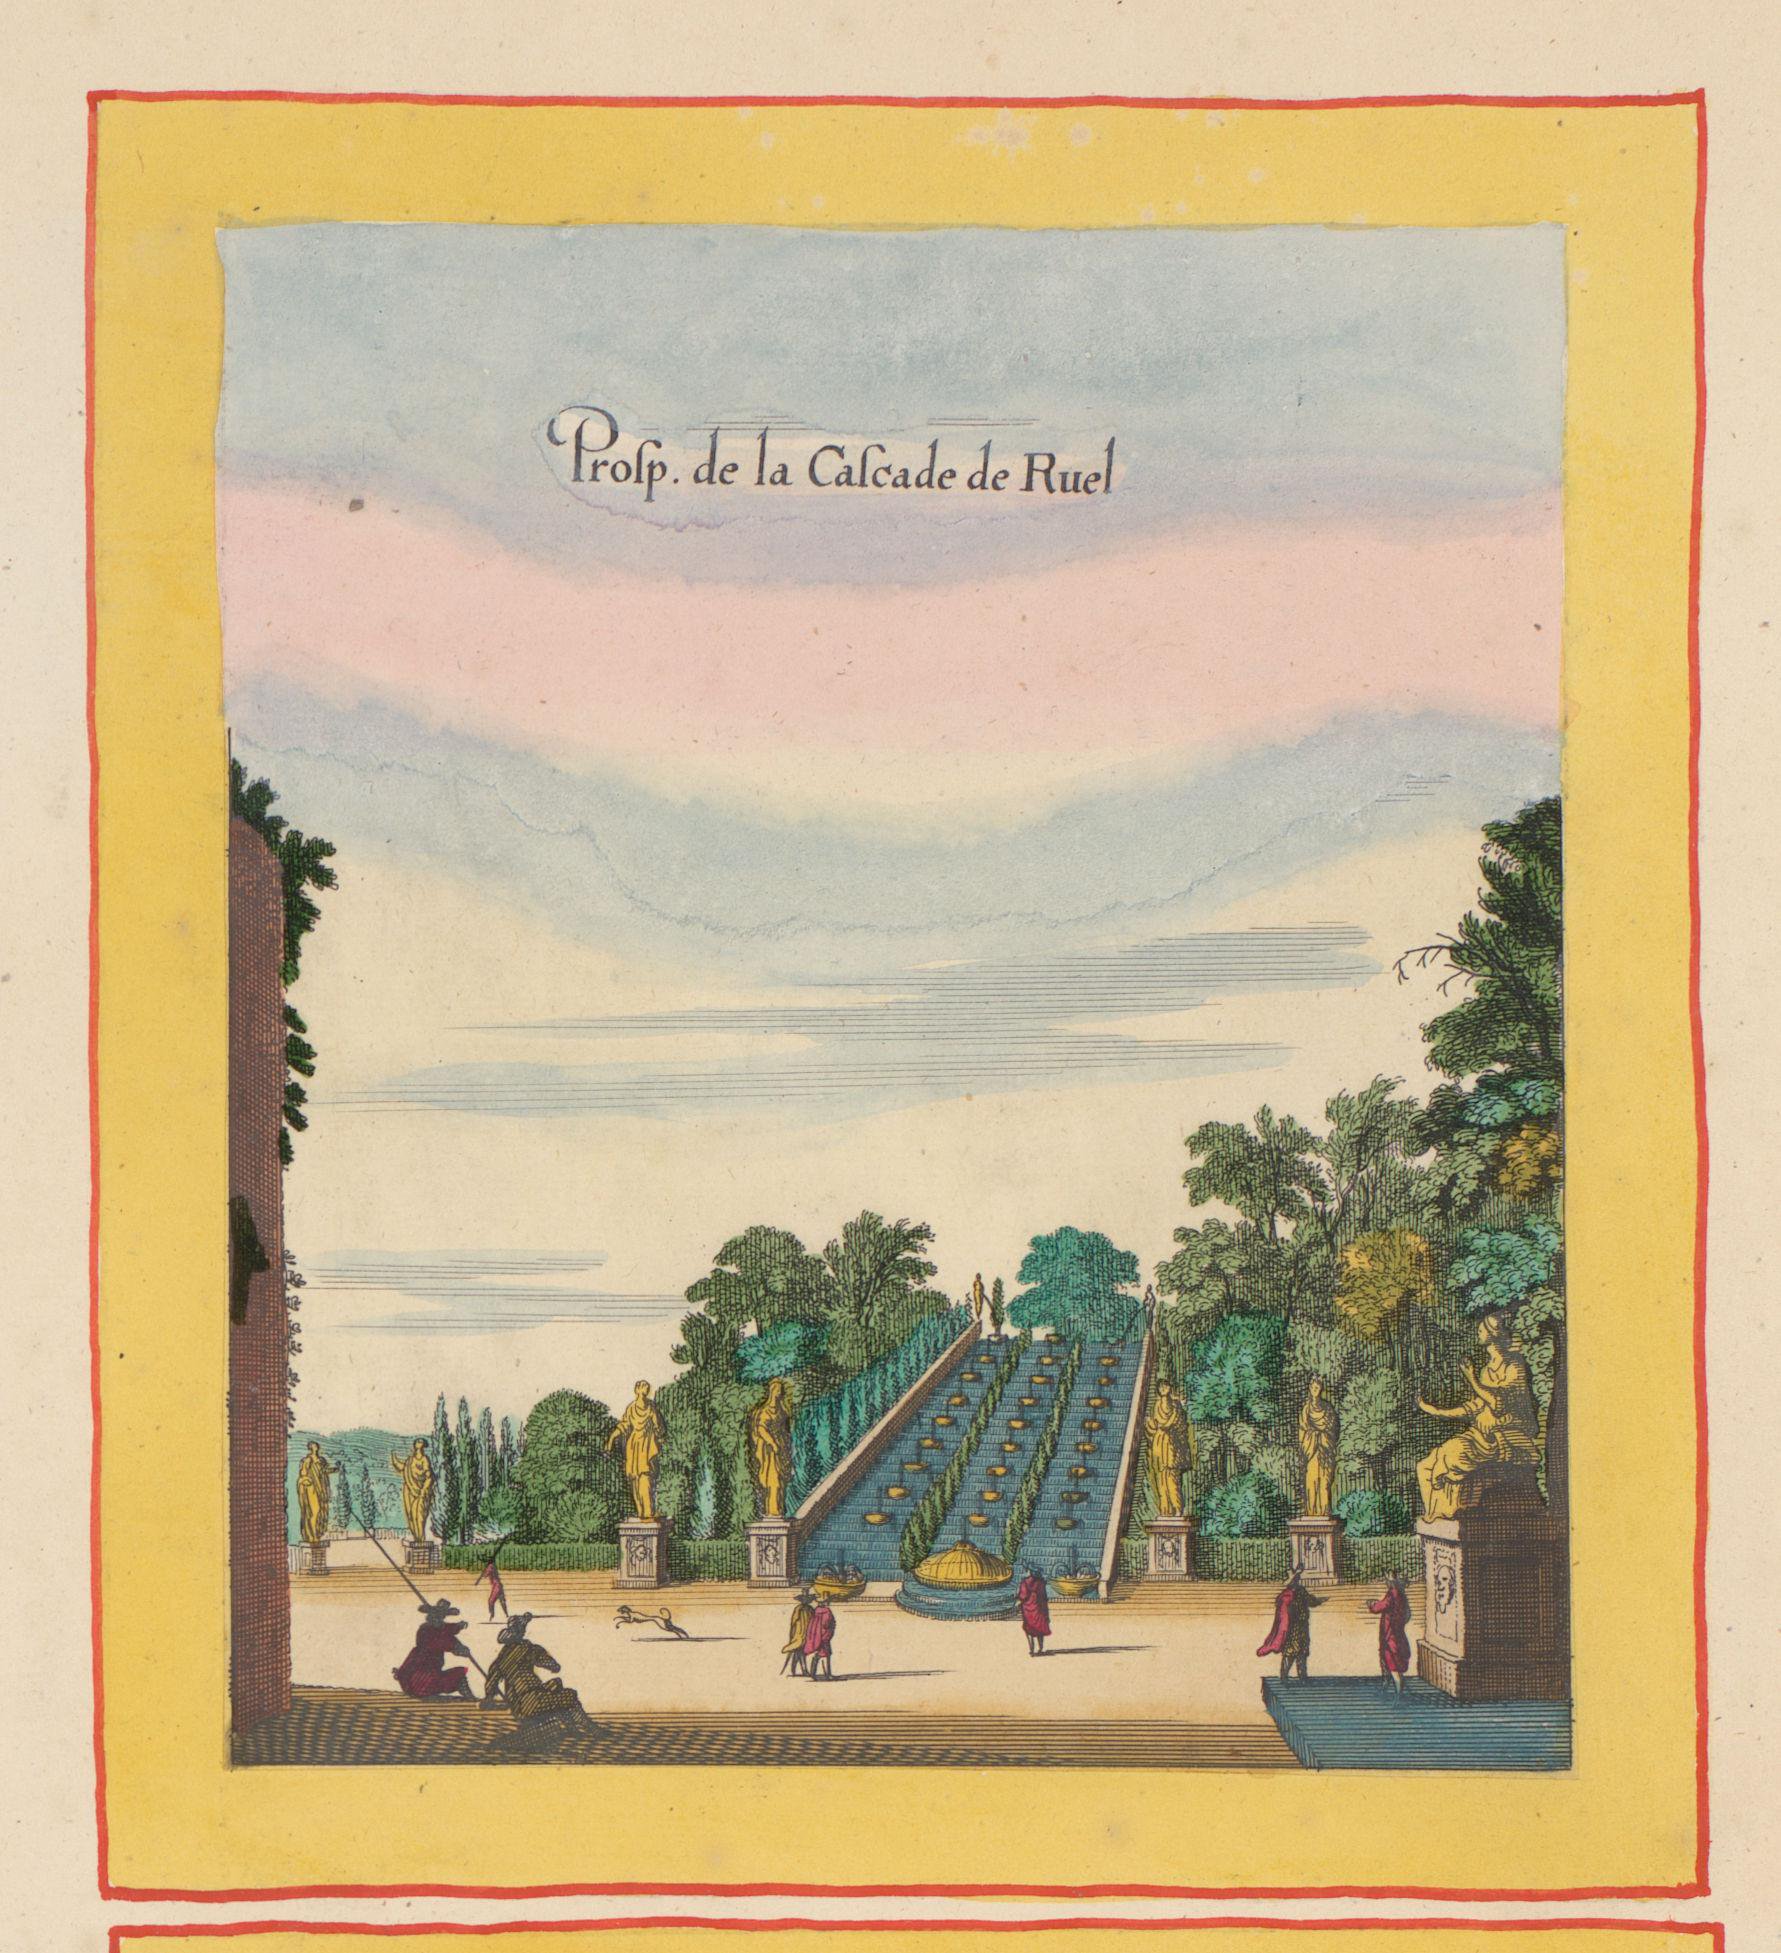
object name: album leaf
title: Gezicht op de cascades in de tuinen van Château du Val de Ruel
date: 1655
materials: paper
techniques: engraving, etching, hand coloring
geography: the hague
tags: garden cascade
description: Prent origineel vervaardigd als boekillustratie voor: Zeiller, Martin. Topographia Galliae, oder Beschreibung und Contrafaitung der vornehmbsten und bekantisten Oerter in dem mächtigen und grossen Königreich Frankreich, 13 delen. Frankfurt am Main: Caspar Merian, 1655-1661. De prent werd voor het eerst gepubliceerd in deel 1: Topographia Galliae, 1655. De prent is langs de bovenrand van de voorstelling afgescheurd. De titel is hoger opgeplakt. De voorstelling is aan de bovenzijde aangevuld met een geschilderde lucht.